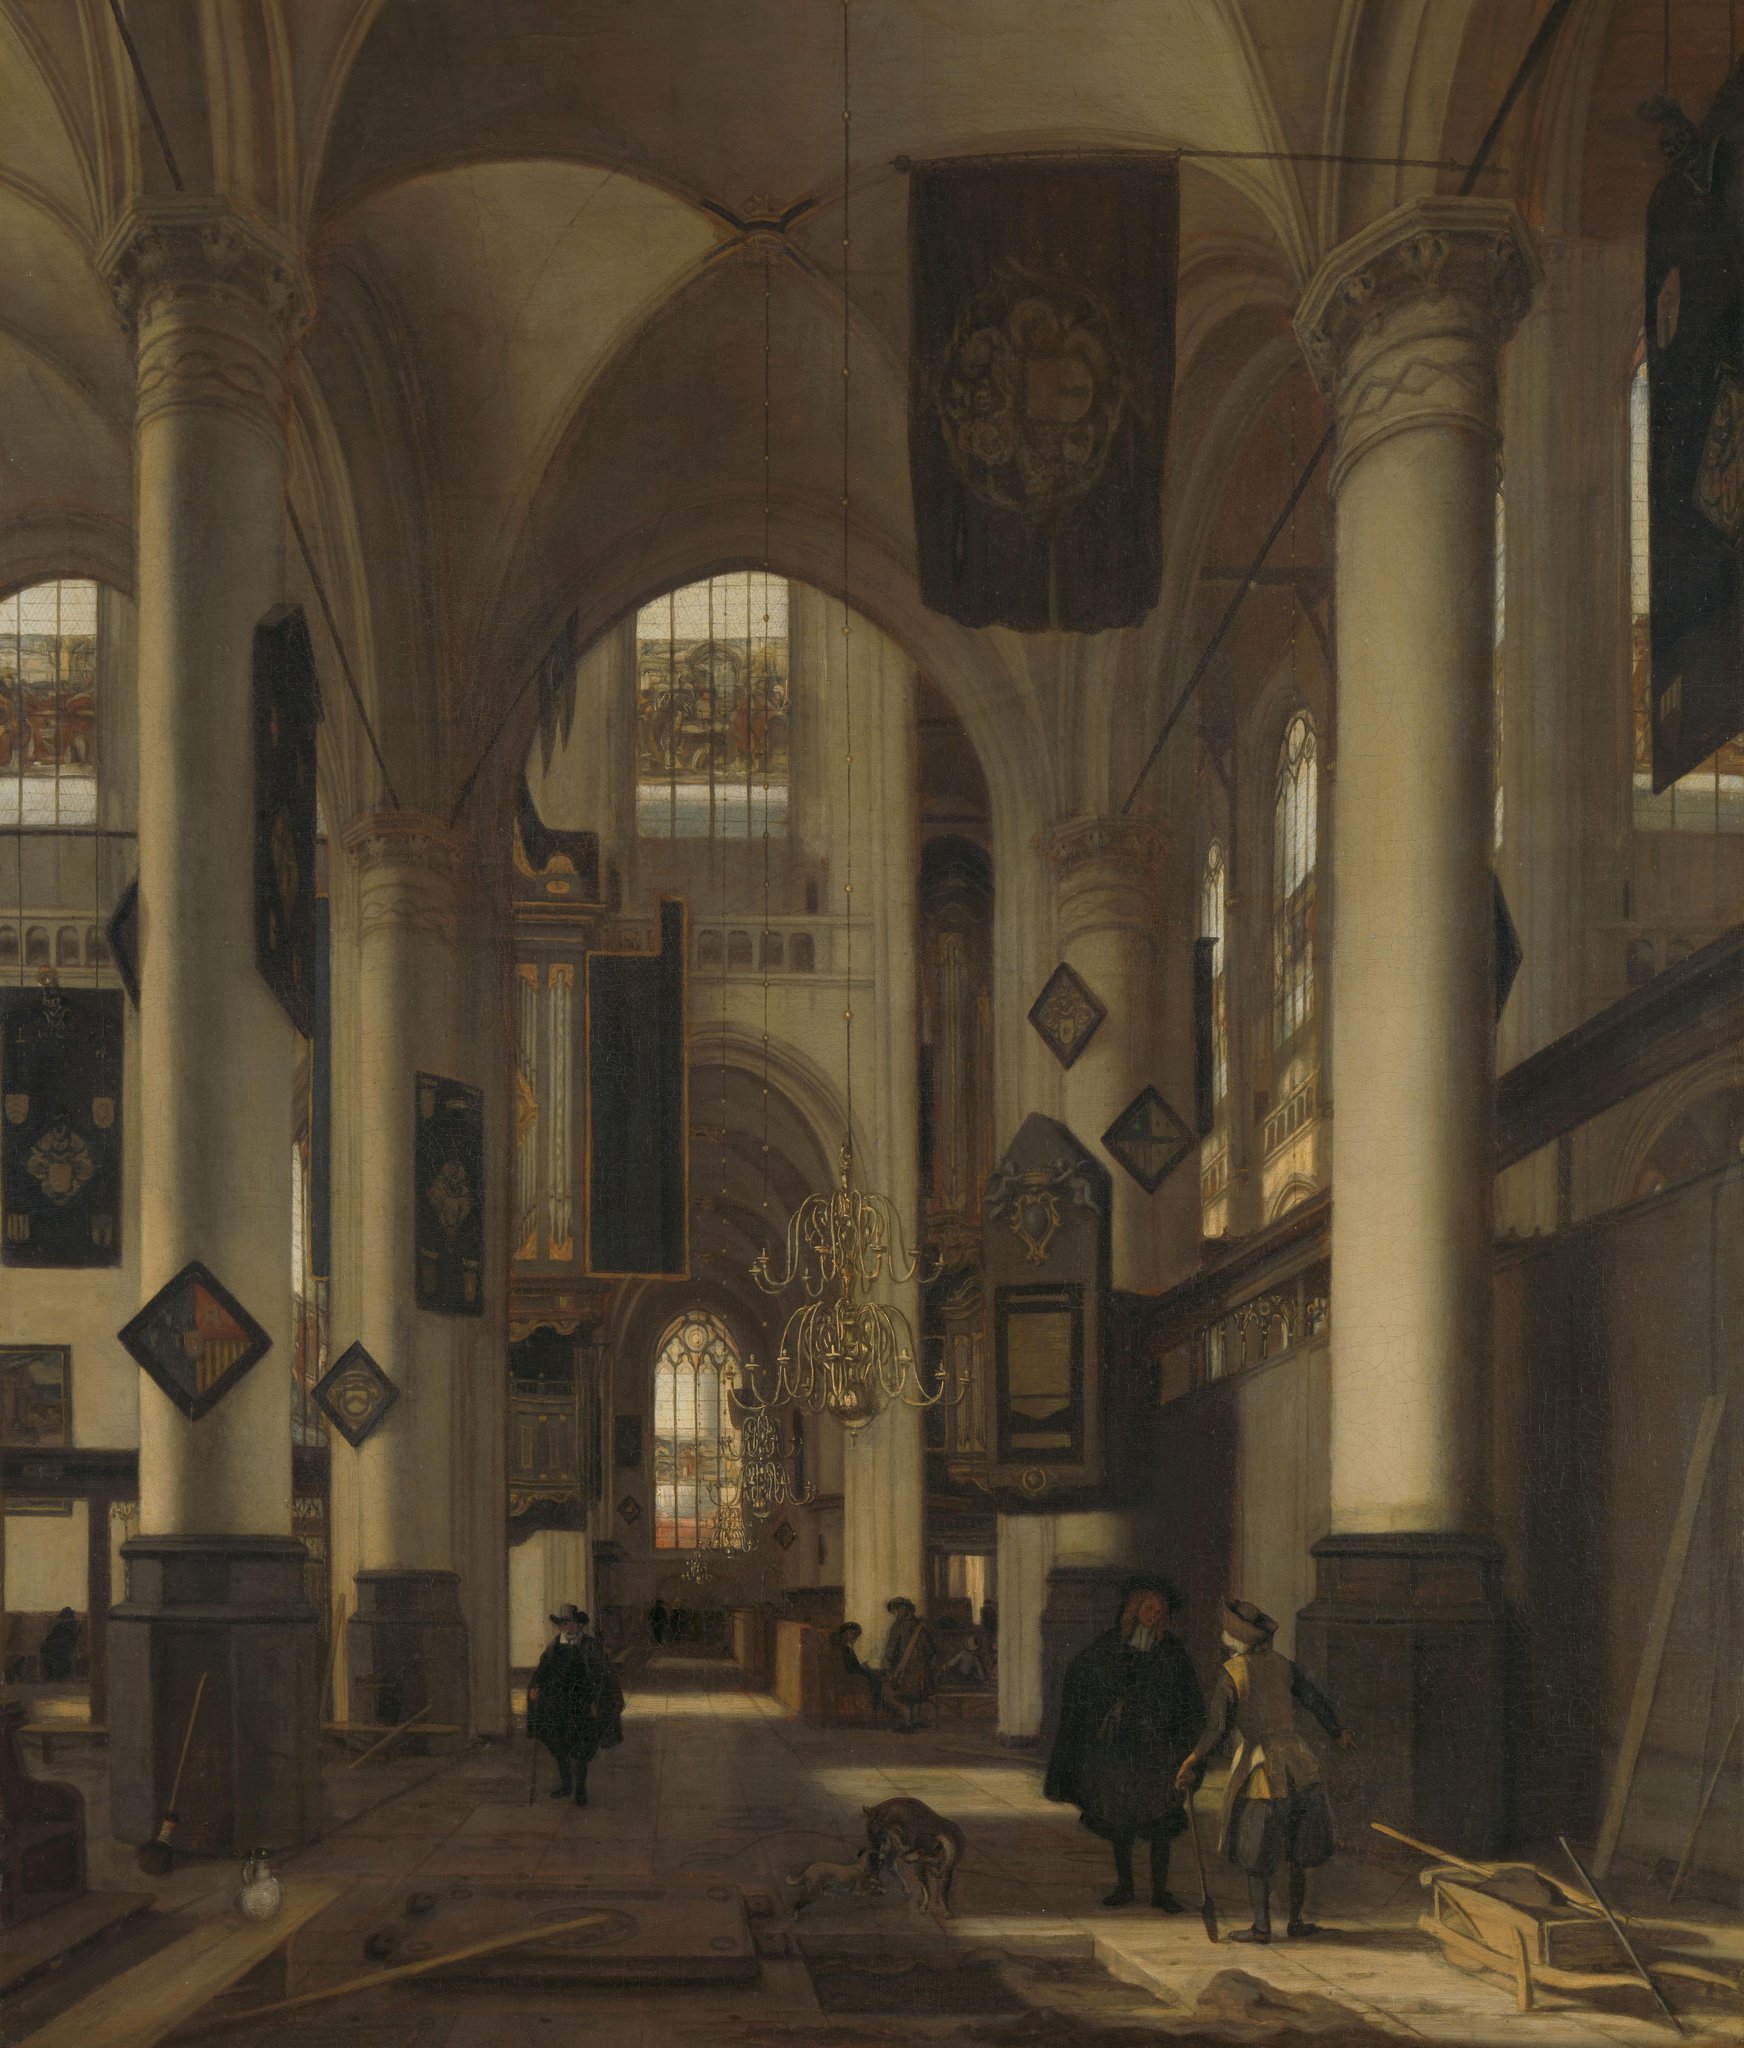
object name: painting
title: Interior of a Protestant Gothic Church with Motifs from the Oude and Nieuwe Kerk in Amsterdam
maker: emanuel de witte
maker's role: painter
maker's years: 1617-1692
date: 1660-1680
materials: canvas, oil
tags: interior of church, grave digger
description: Interieur van een protestantse gotische kerk met motieven van de Oude en de Nieuwe Kerk te Amsterdam. Gezicht in de kooromgang waar een man spreekt met een grafdelver. Bij het geopend graf spelen twee honden